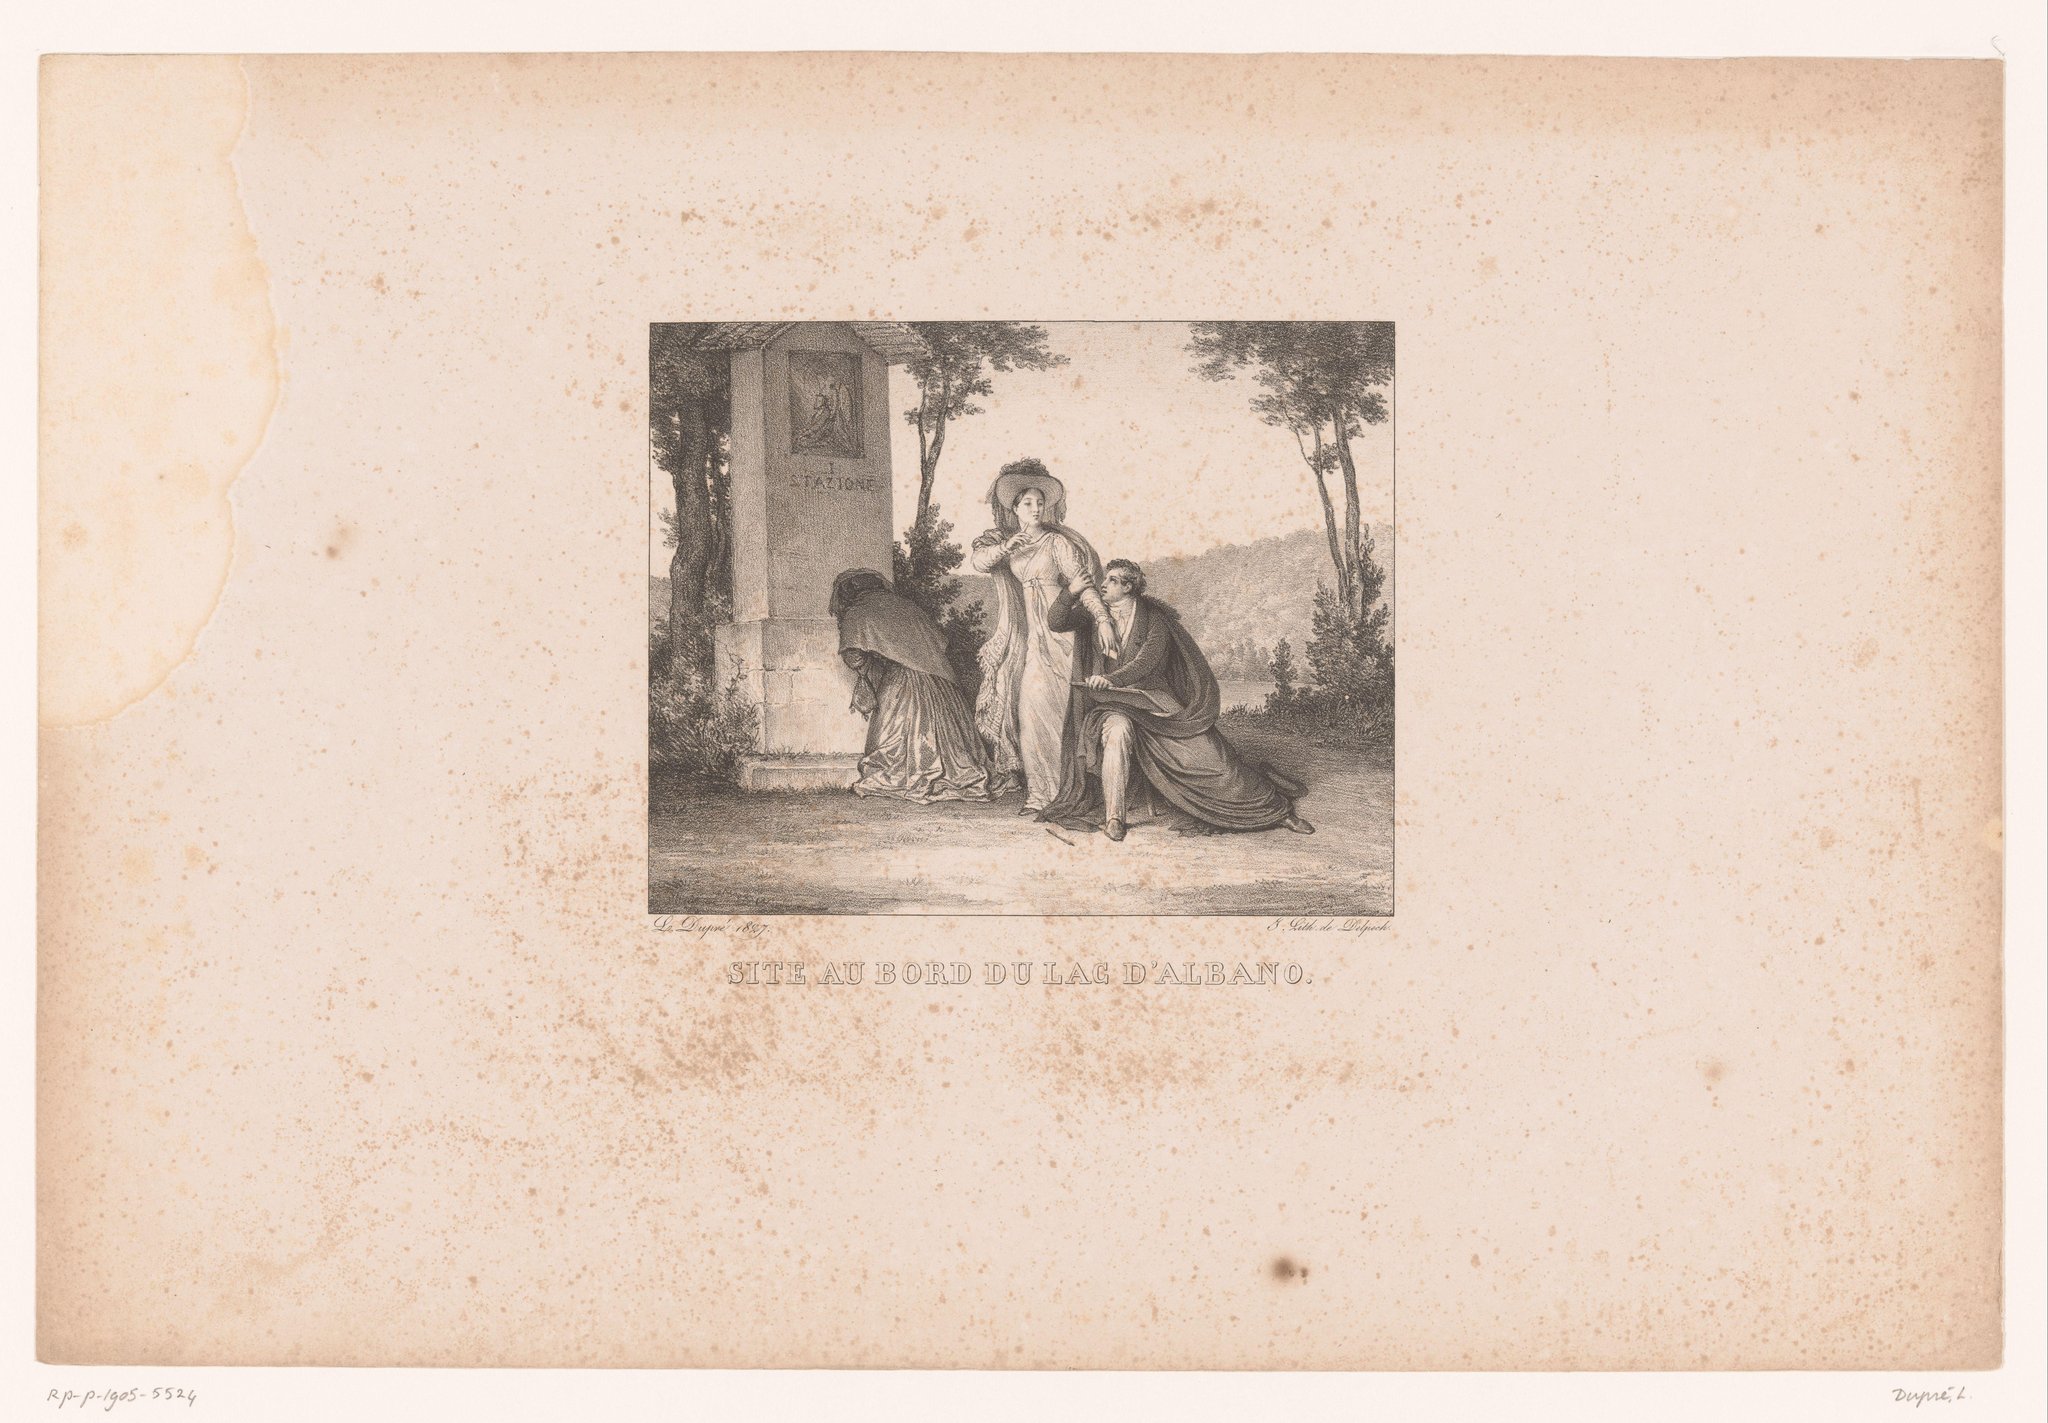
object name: print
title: Site au bord du Lac d'Albano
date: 1827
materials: paper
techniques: lithograph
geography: paris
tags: stations of the cross, lake, draughtsman at work - cc - out of doors, couple of lovers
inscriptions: collector's mark: Lugt 2228a